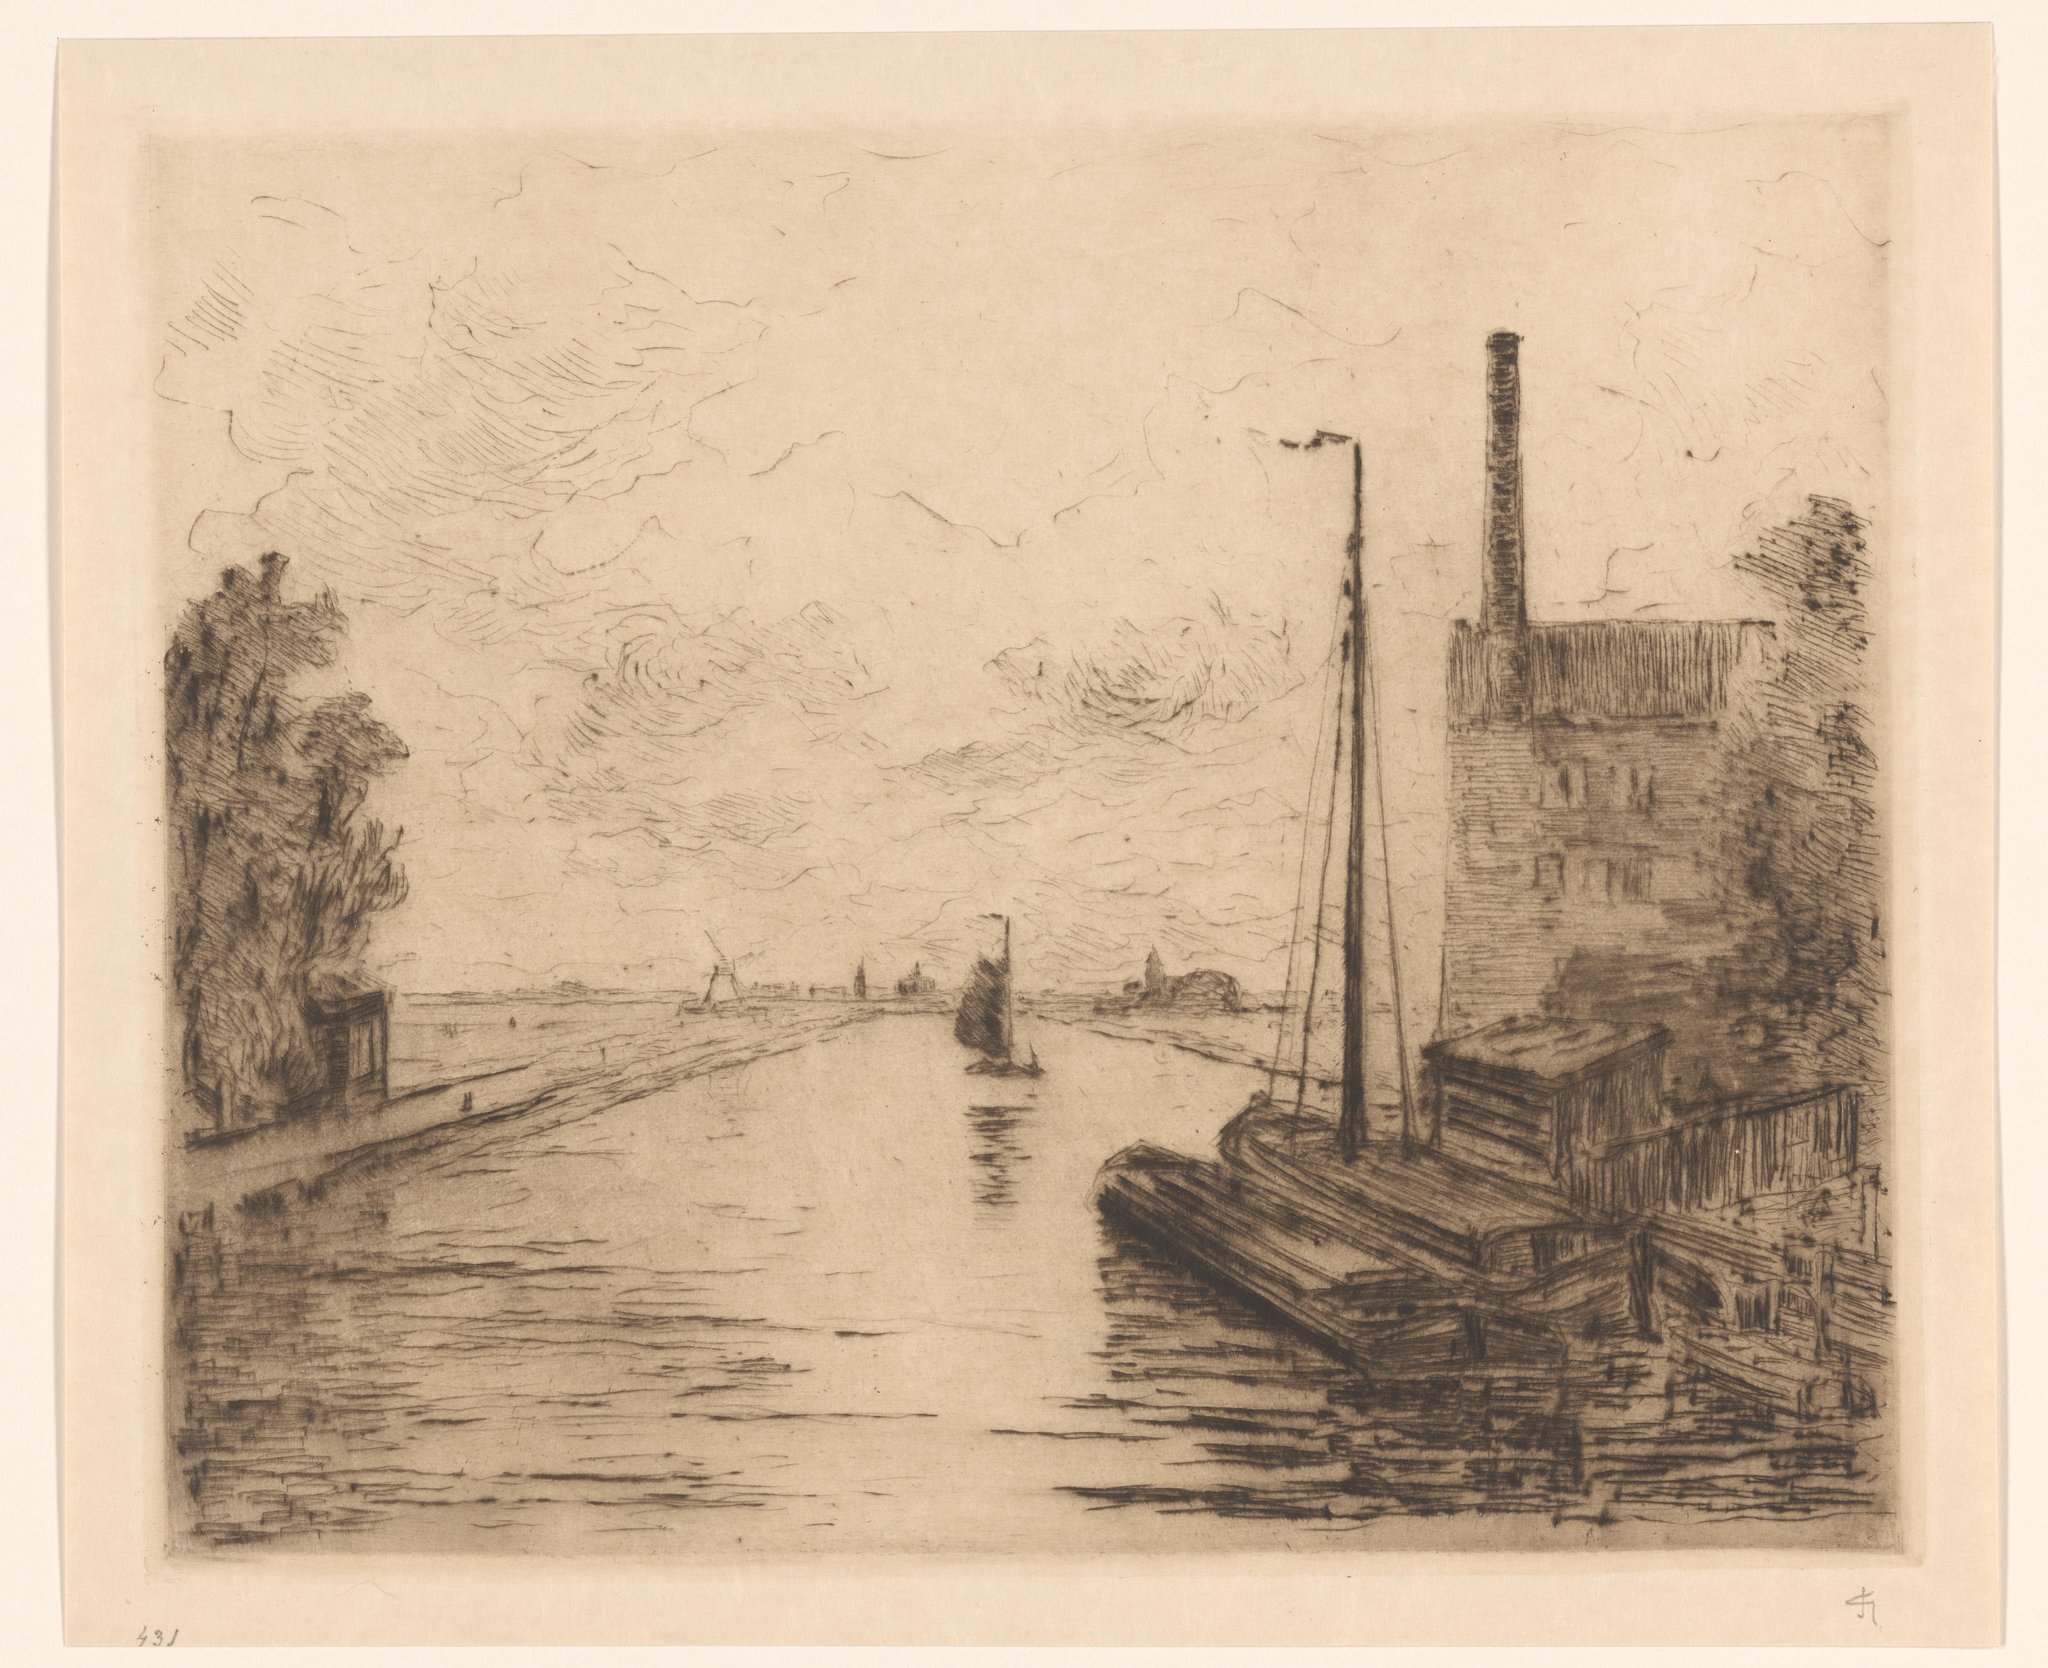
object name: print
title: Gezicht op een kanaal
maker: carel nicolaas storm van s-gravesande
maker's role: draughtsman, print maker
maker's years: 1841-1924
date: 1851-1902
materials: paper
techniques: drypoint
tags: windmill in landscape, canal (+ landscape with figures, staffage)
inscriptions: collector's mark: Lugt 2228, number: ‘431’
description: Mogelijk vermeld in: Storm van 's-Gravesande, Charles. Catalogue des eaux-fortes et lithographies. New York: s.n., 1903, of in een onbekende latere uitgave van het manuscript. Vermoedelijk vermeld als catalogusnummer 431.